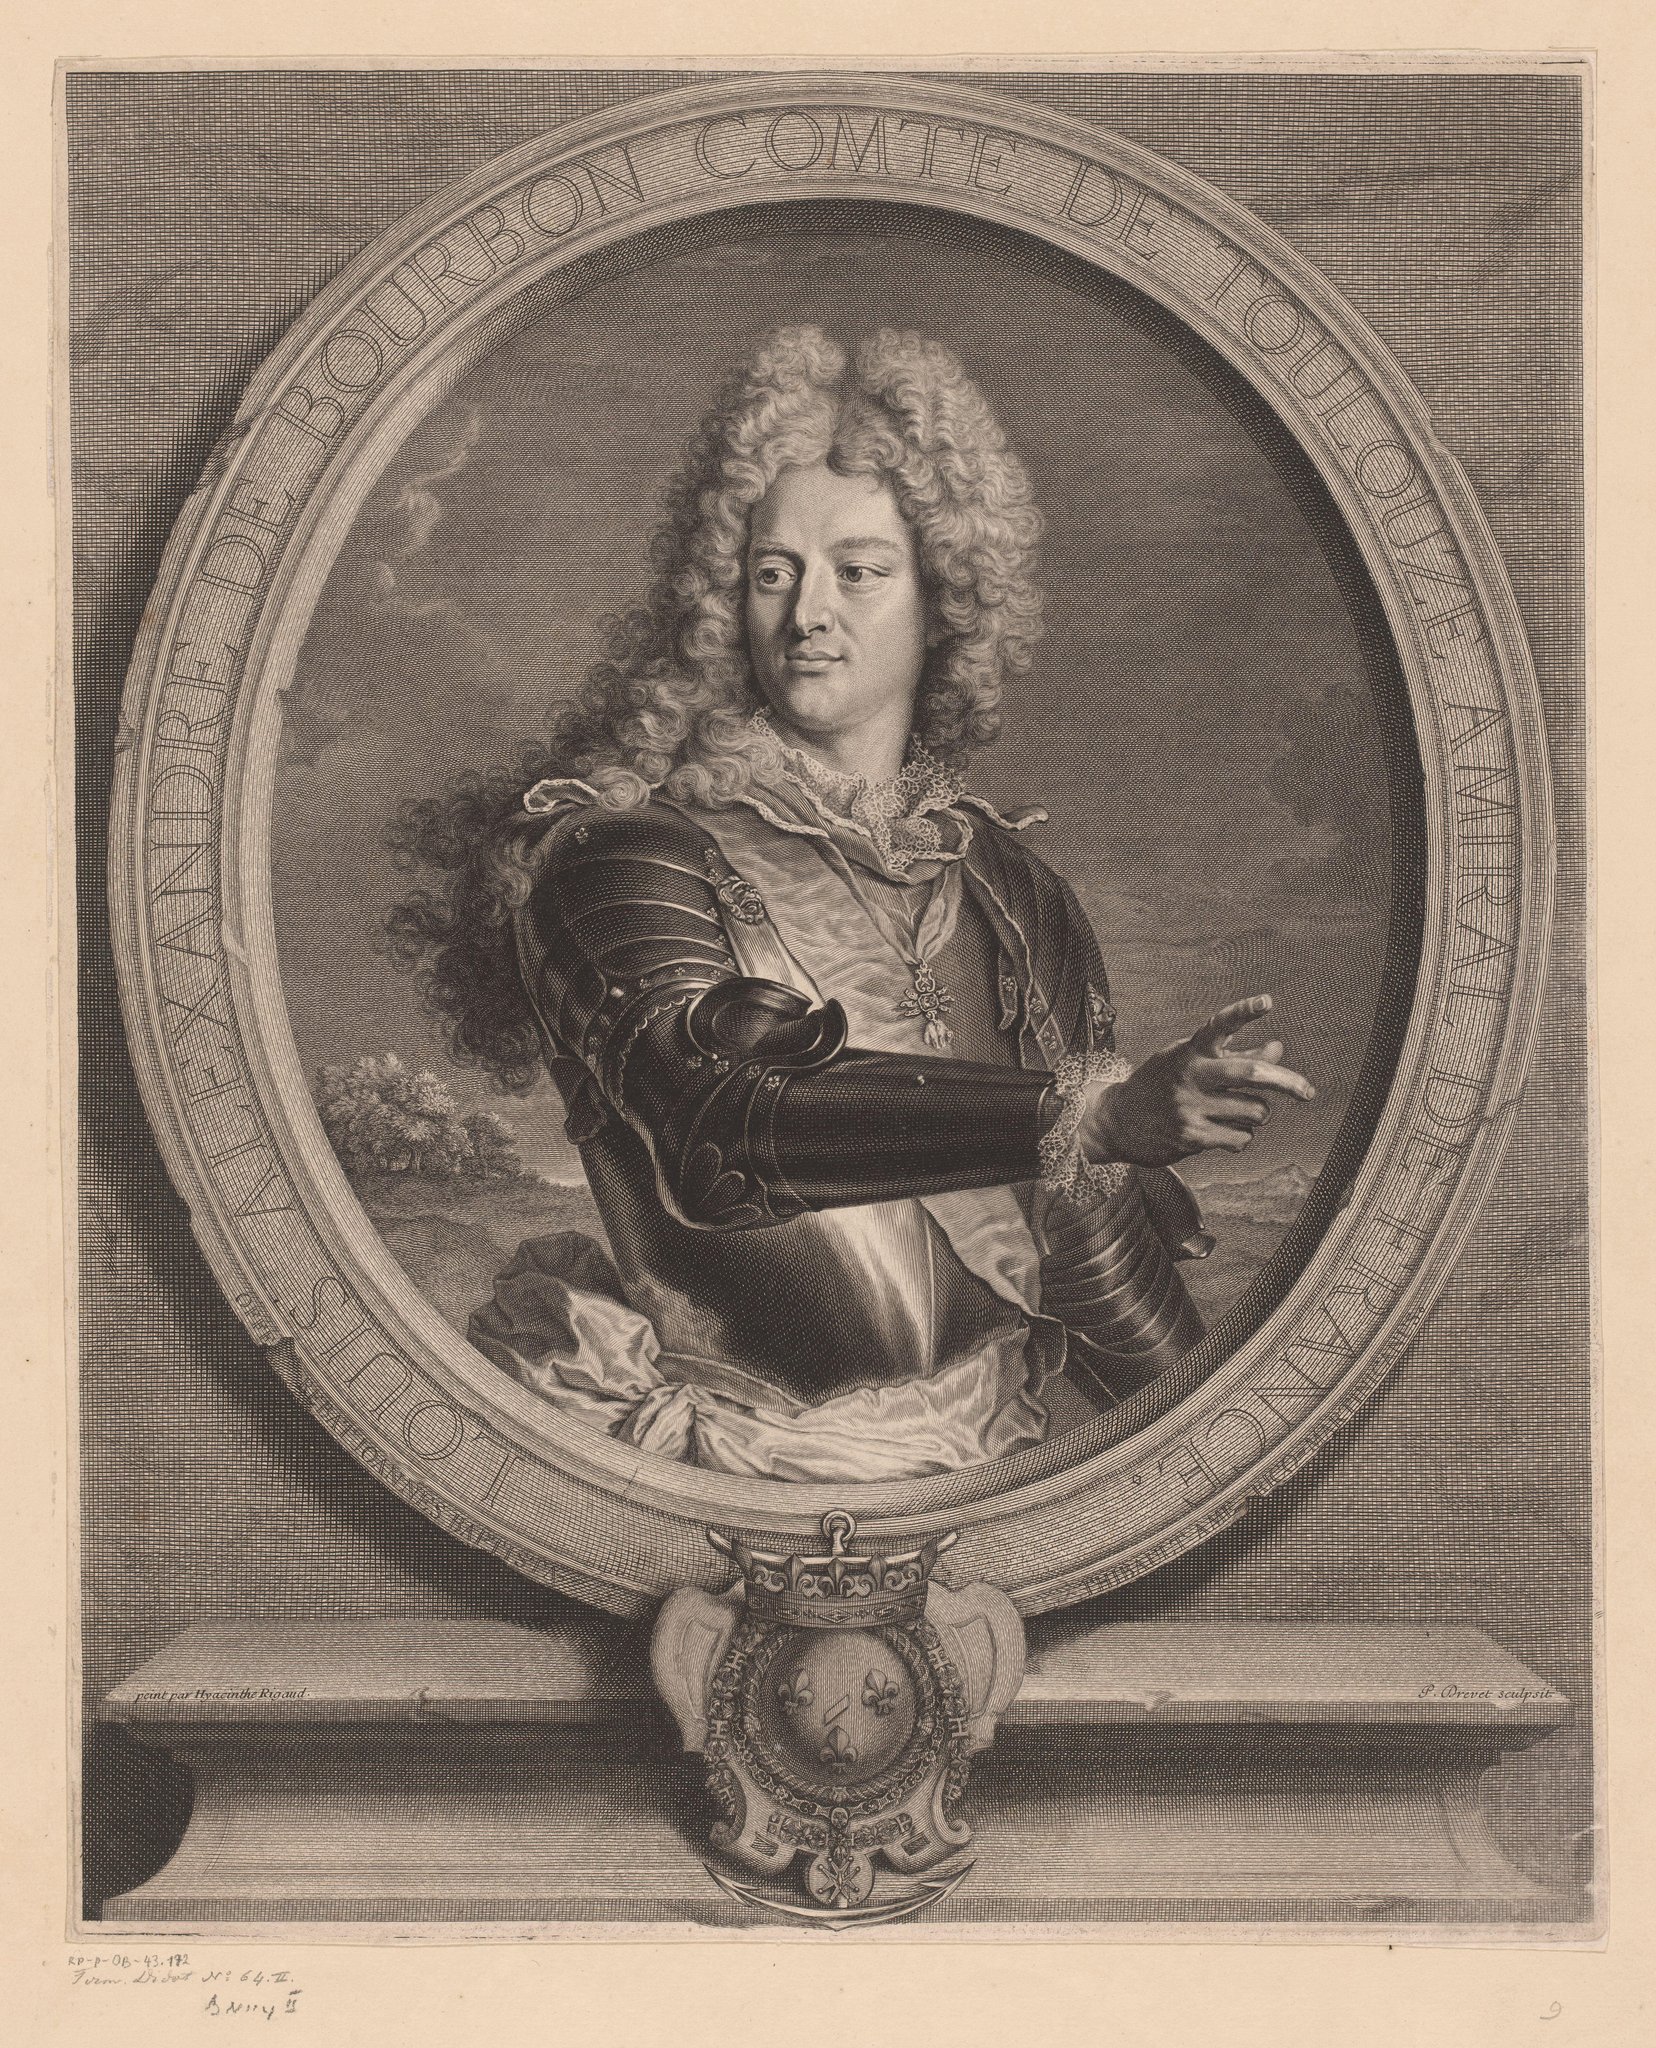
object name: print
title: Louis Alexandre de Bourbon comte de Toulouze amiral de France.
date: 1714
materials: paper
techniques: engraving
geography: france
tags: louis alexandre (count of toulouse), ornament ~ medallion, armour, historical persons, knighthood order of the golden fleece - insignia of a knighthood order, e.g.: badge, chain (with name of order), armorial bearing, heraldry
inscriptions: collector's mark: Lugt 240